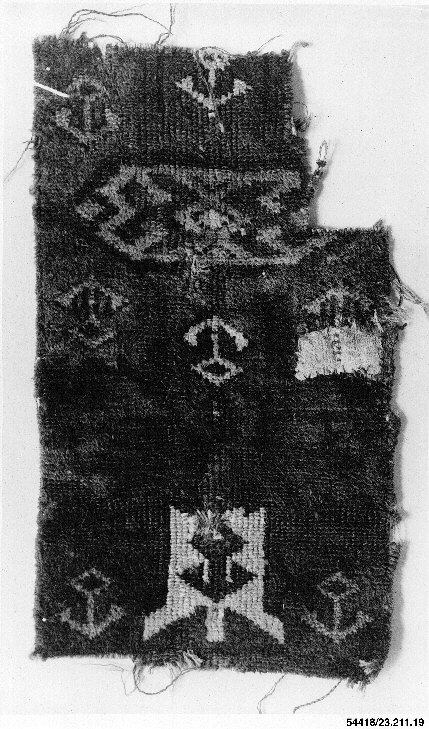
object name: carpet fragment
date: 1701-1800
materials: wool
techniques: pile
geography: central asia